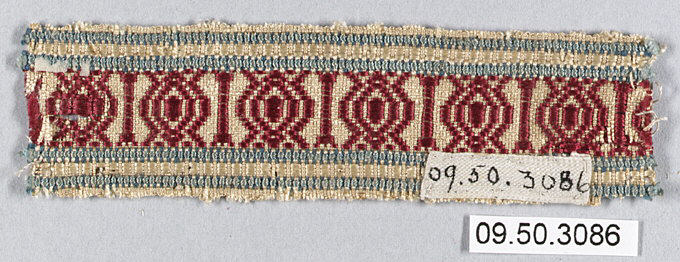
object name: gimp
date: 1701-1900